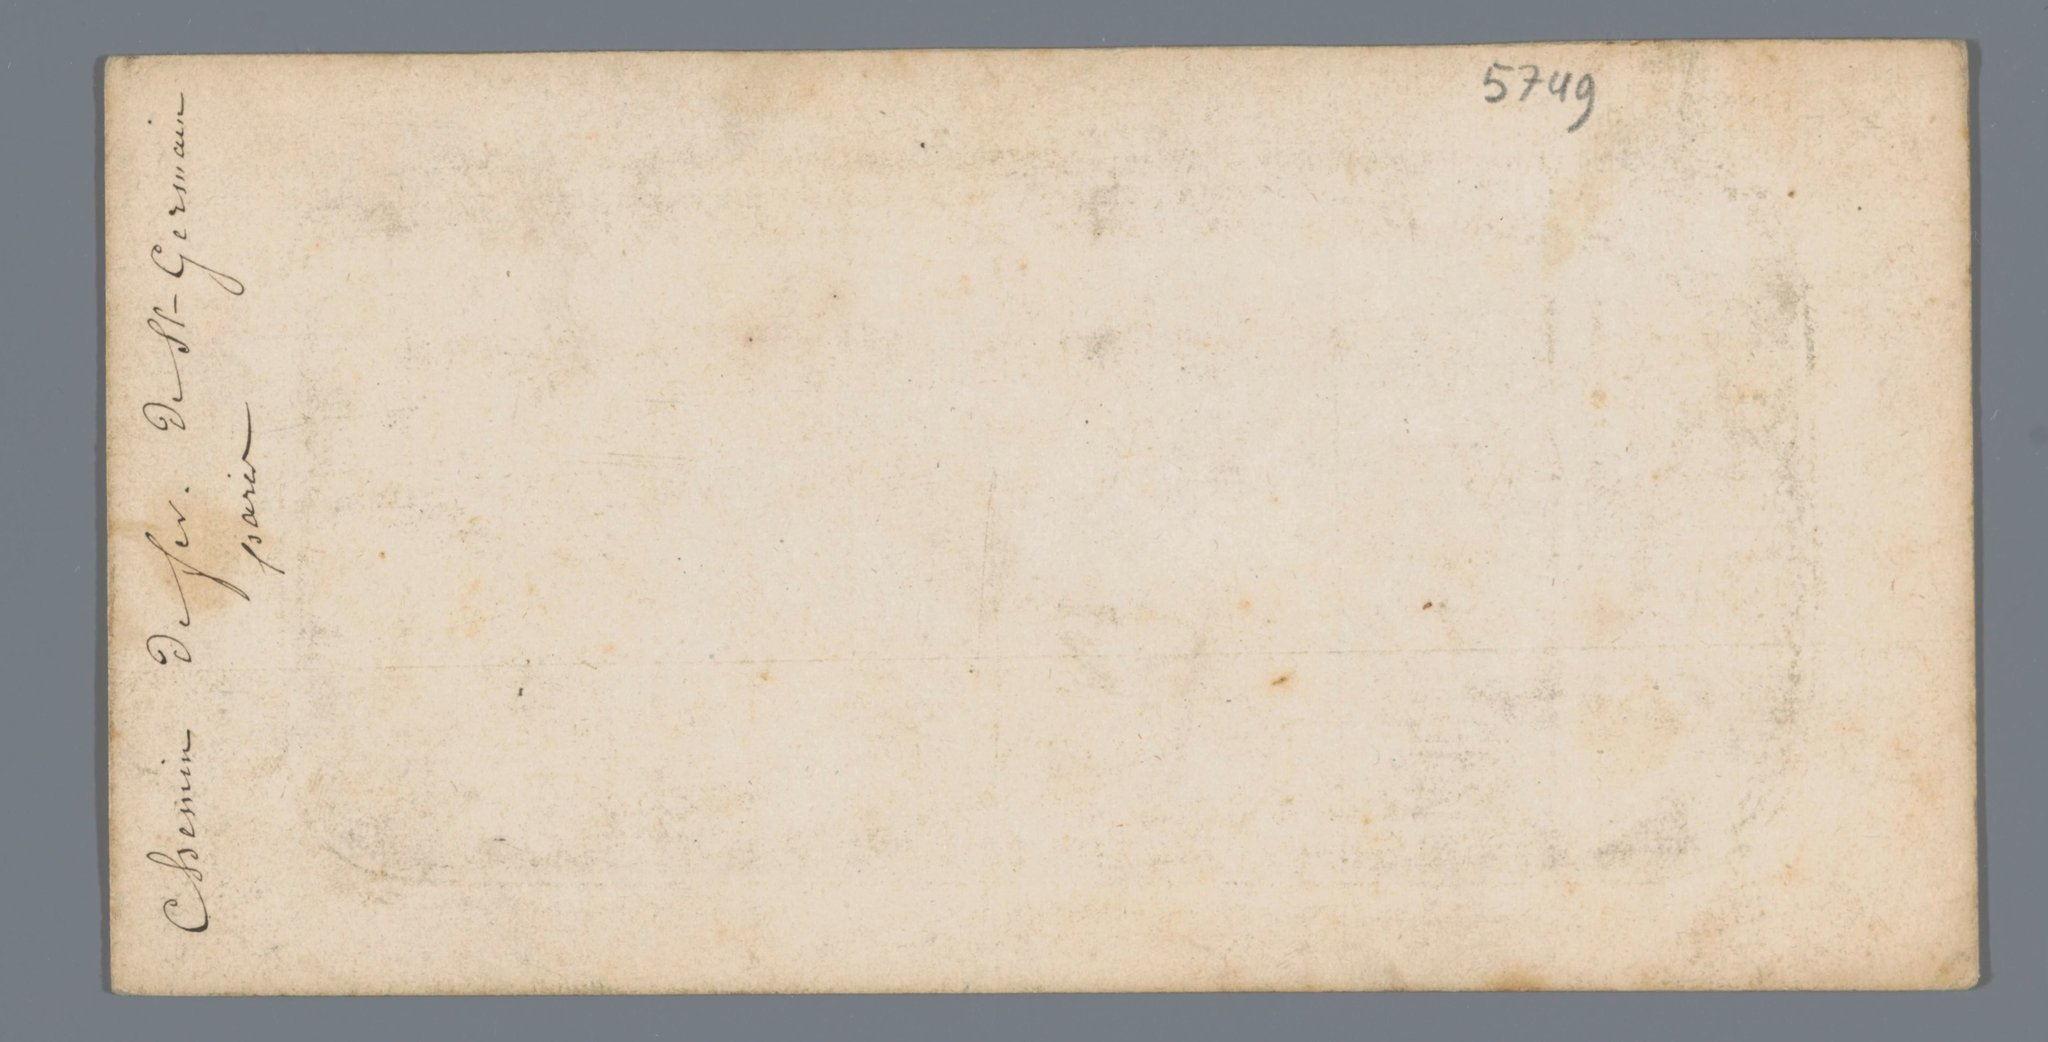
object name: stereograph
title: Gezicht op een spoorbaan in Parijs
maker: Anonymous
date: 1855-1860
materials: cardboard, photographic support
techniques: albumen print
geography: paris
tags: railway, train, paris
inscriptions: inscription: ‘Chemin de fer de St Germain Paris’